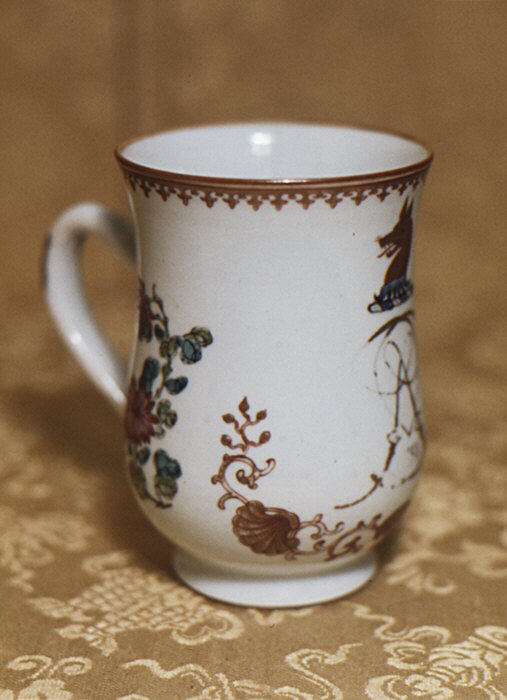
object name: mug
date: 1758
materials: hard paste porcelain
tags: flowers,insignia